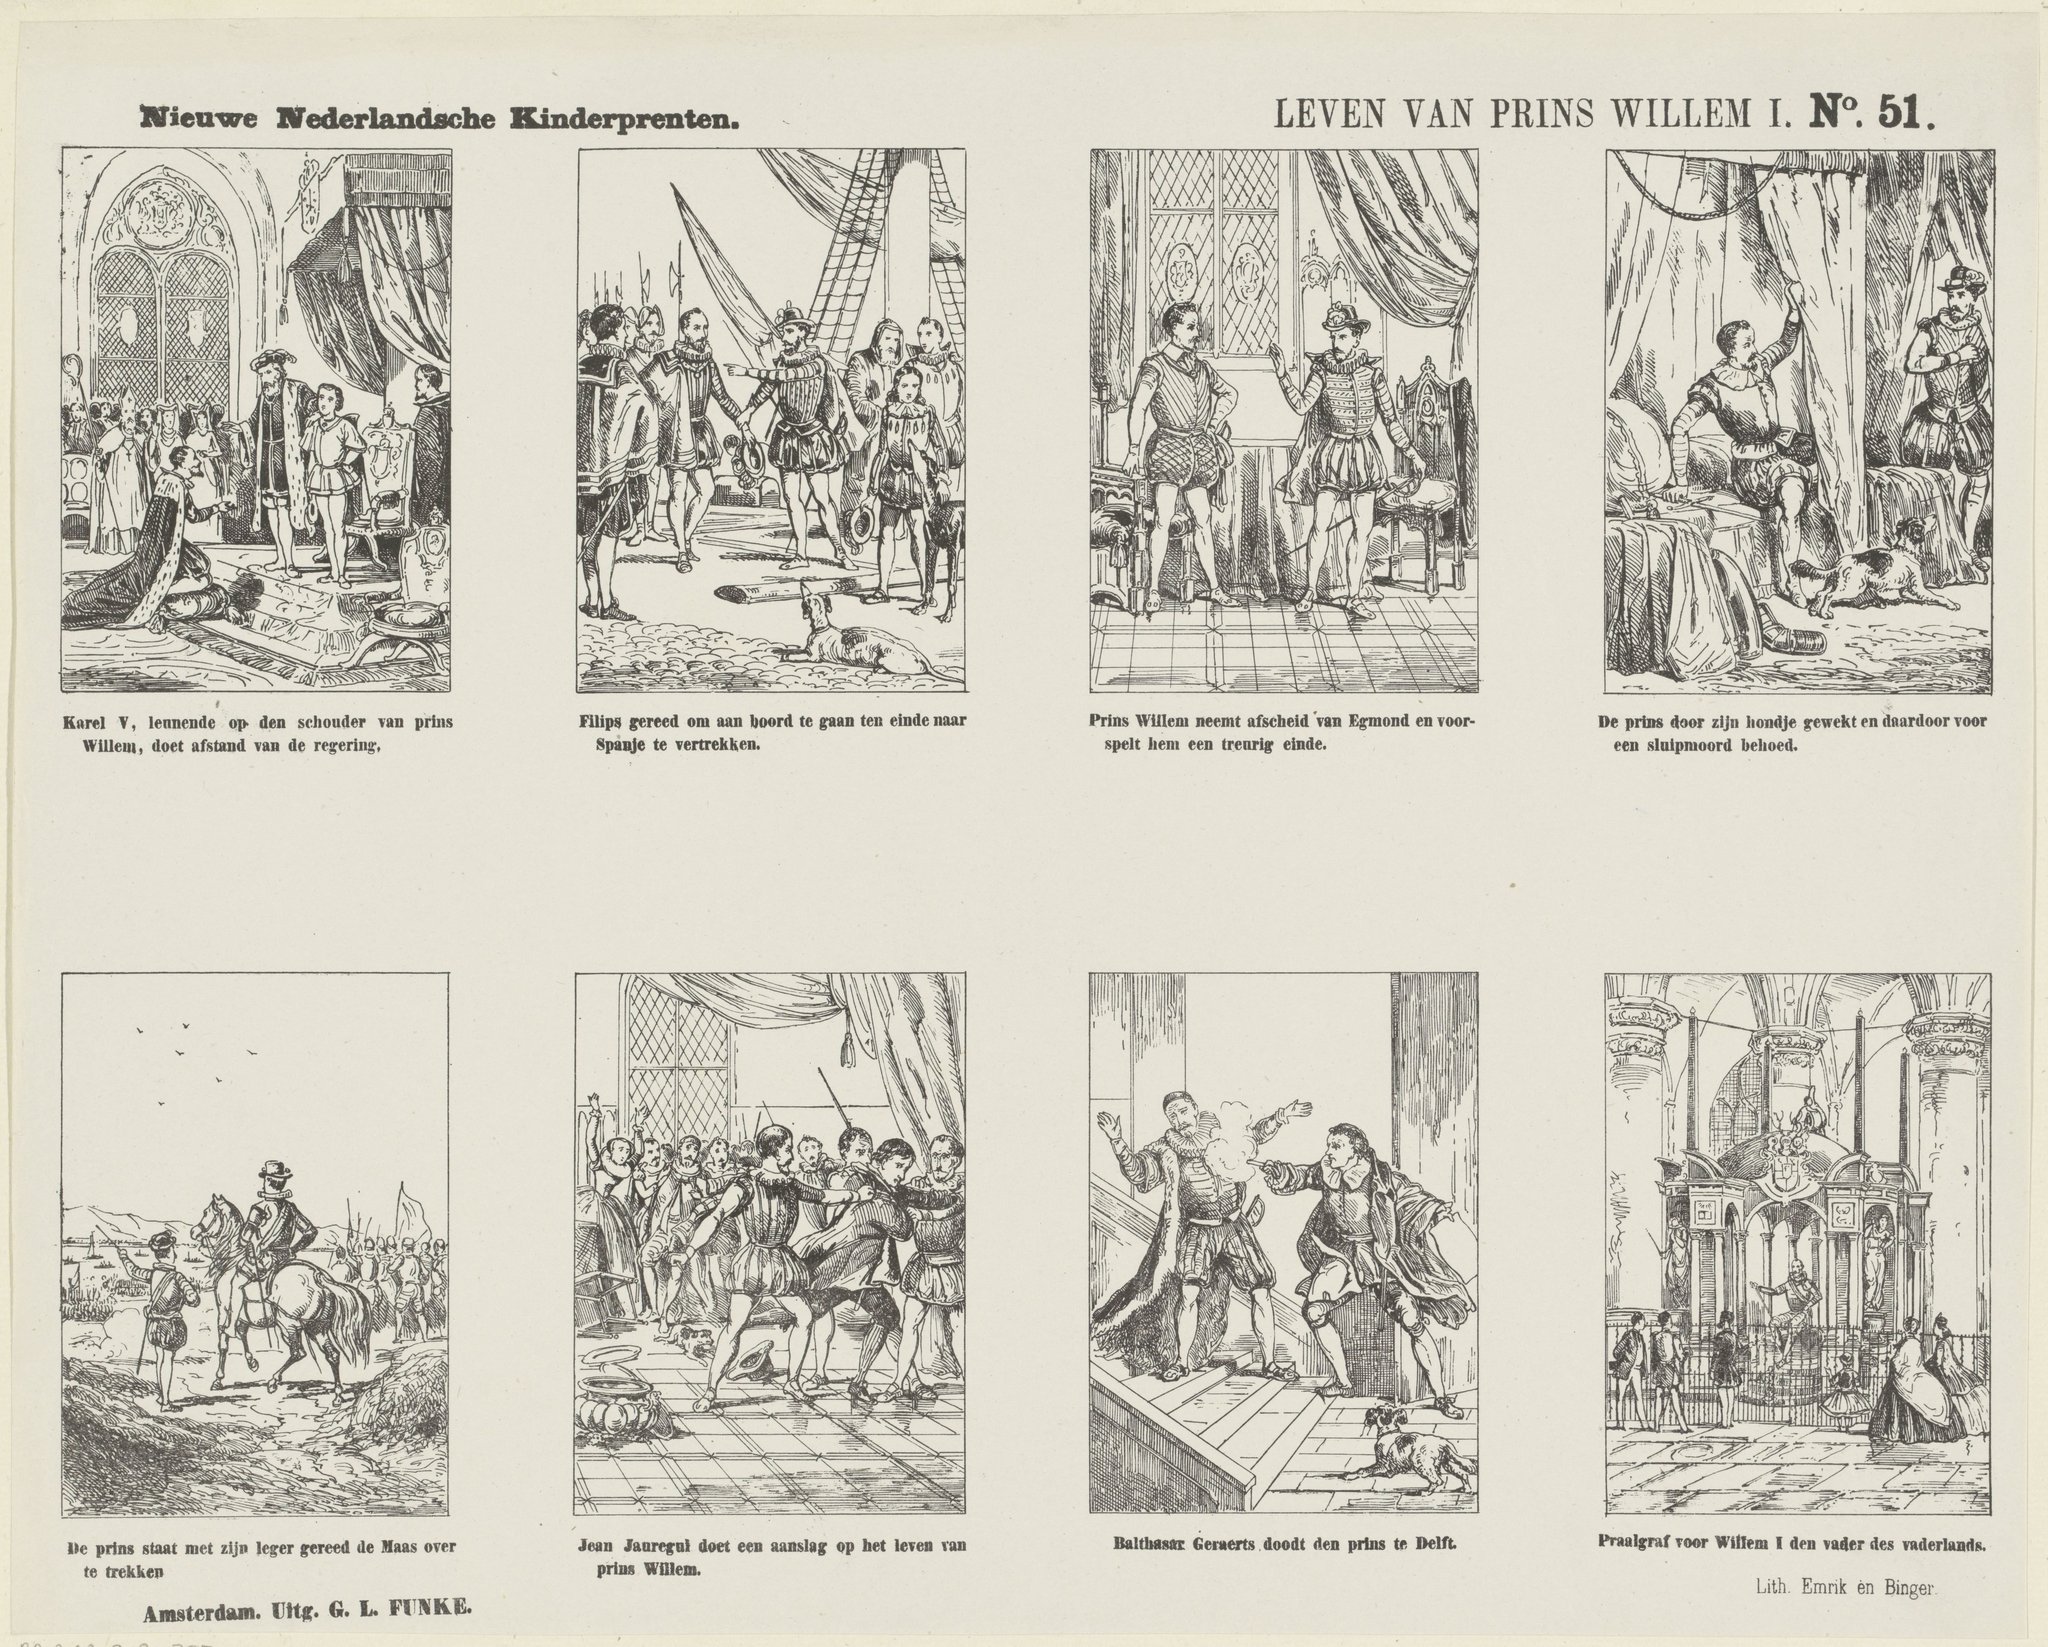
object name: print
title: Leven van prins Willem I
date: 1865-1875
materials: paper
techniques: letterpress printing, lithograph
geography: amsterdam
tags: philip ii of spain, delft, william i (prince of orange), charles v (holy roman emperor and king of spain)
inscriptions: collector's mark: Lugt 2760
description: Blad met 8 voorstellingen over het leven van Willem I. Onder elke afbeelding een tweeregelig vers. Genummerd rechtsboven: No. 51.